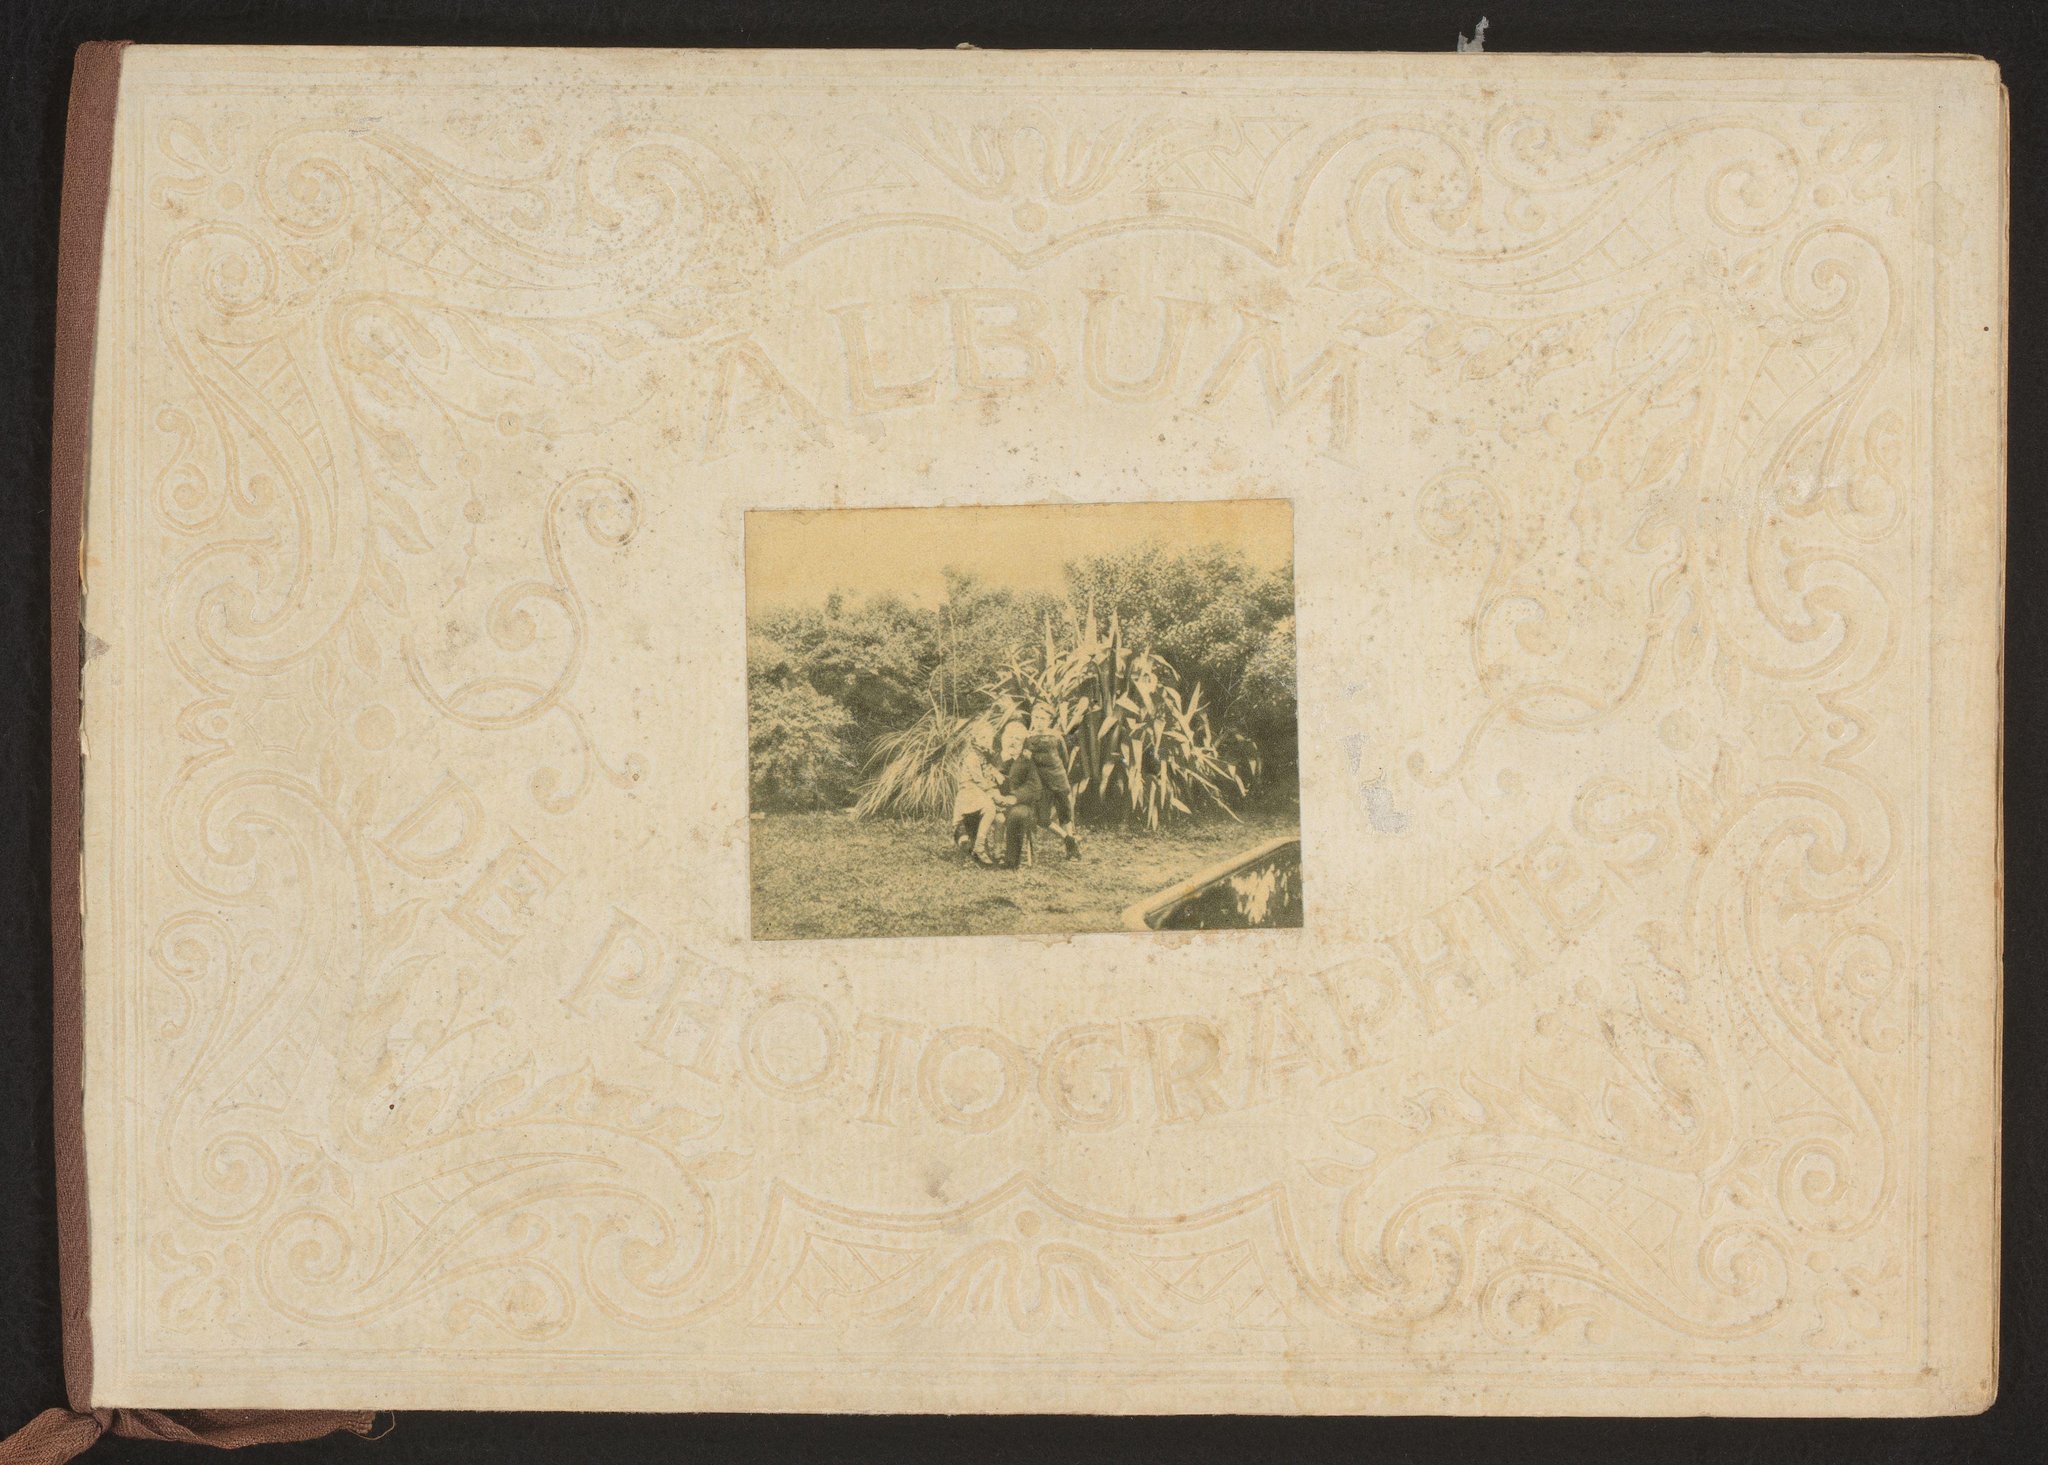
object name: scrapbook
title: Dans l'intimité de personnages illustres 1860-1905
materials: cardboard, paper, photographic support, textile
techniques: lithograph, rotogravure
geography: france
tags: paris, london, napoleon iii (keizer der fransen), physicist, charles baudelaire, painter, print maker, edouard manet, victor hugo, stéphane mallarmé, lyon, paul féval, jules gabriel janin, portrait of actor, actress, writer, poet, author, science and technology (+ portrait of scholar, scientist), artist (in general), france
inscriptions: inscription: ‘Une Critique/ Sous la signature d'Aurélien Scholl, l'ÉVENEMENT a publié/ une épigramme oú le spirituel chroniqueur raille les Albums de pho-/ tographies que lui montra un ami commun, M. de Villemessant, à qui/ je les avais confés/ [krantenbericht]/ Je feignis de n'avoir point commaissance de cette diatribe. Et,/ quelques mois plus tard, collectioneur impénitent, je sollicitai du/ verveux polémiste sa photographie pour l'insérer dans un "Album/ de personnages illustres". Il me la fit parvenir en toute déligence./ A présent qu' Aurélien Scholl figure en bonne place dans/ mon "Panthéon", ormons l'espoir, si mes modestes efforts attirent à/ nouveau son attention, qu'il en parlera cette fois avec plus d'in-/ dulgence./ J.M. Dufrénoy/ 22 Décembre 1897’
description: Plakboek met 25 portretten van bekende Franse wetenschappers, kunstenaars, auteurs, theatermakers, politici en regeringsleiders verdeeld over 9 bladen, samengesteld door J.M. Dufrénoy in reactie op zijn grootvader, Pierre-Marie Lizerolles, die hiermee begonnen was. Deel 3. Op het voorplat een rotogravure van een groepsportret.